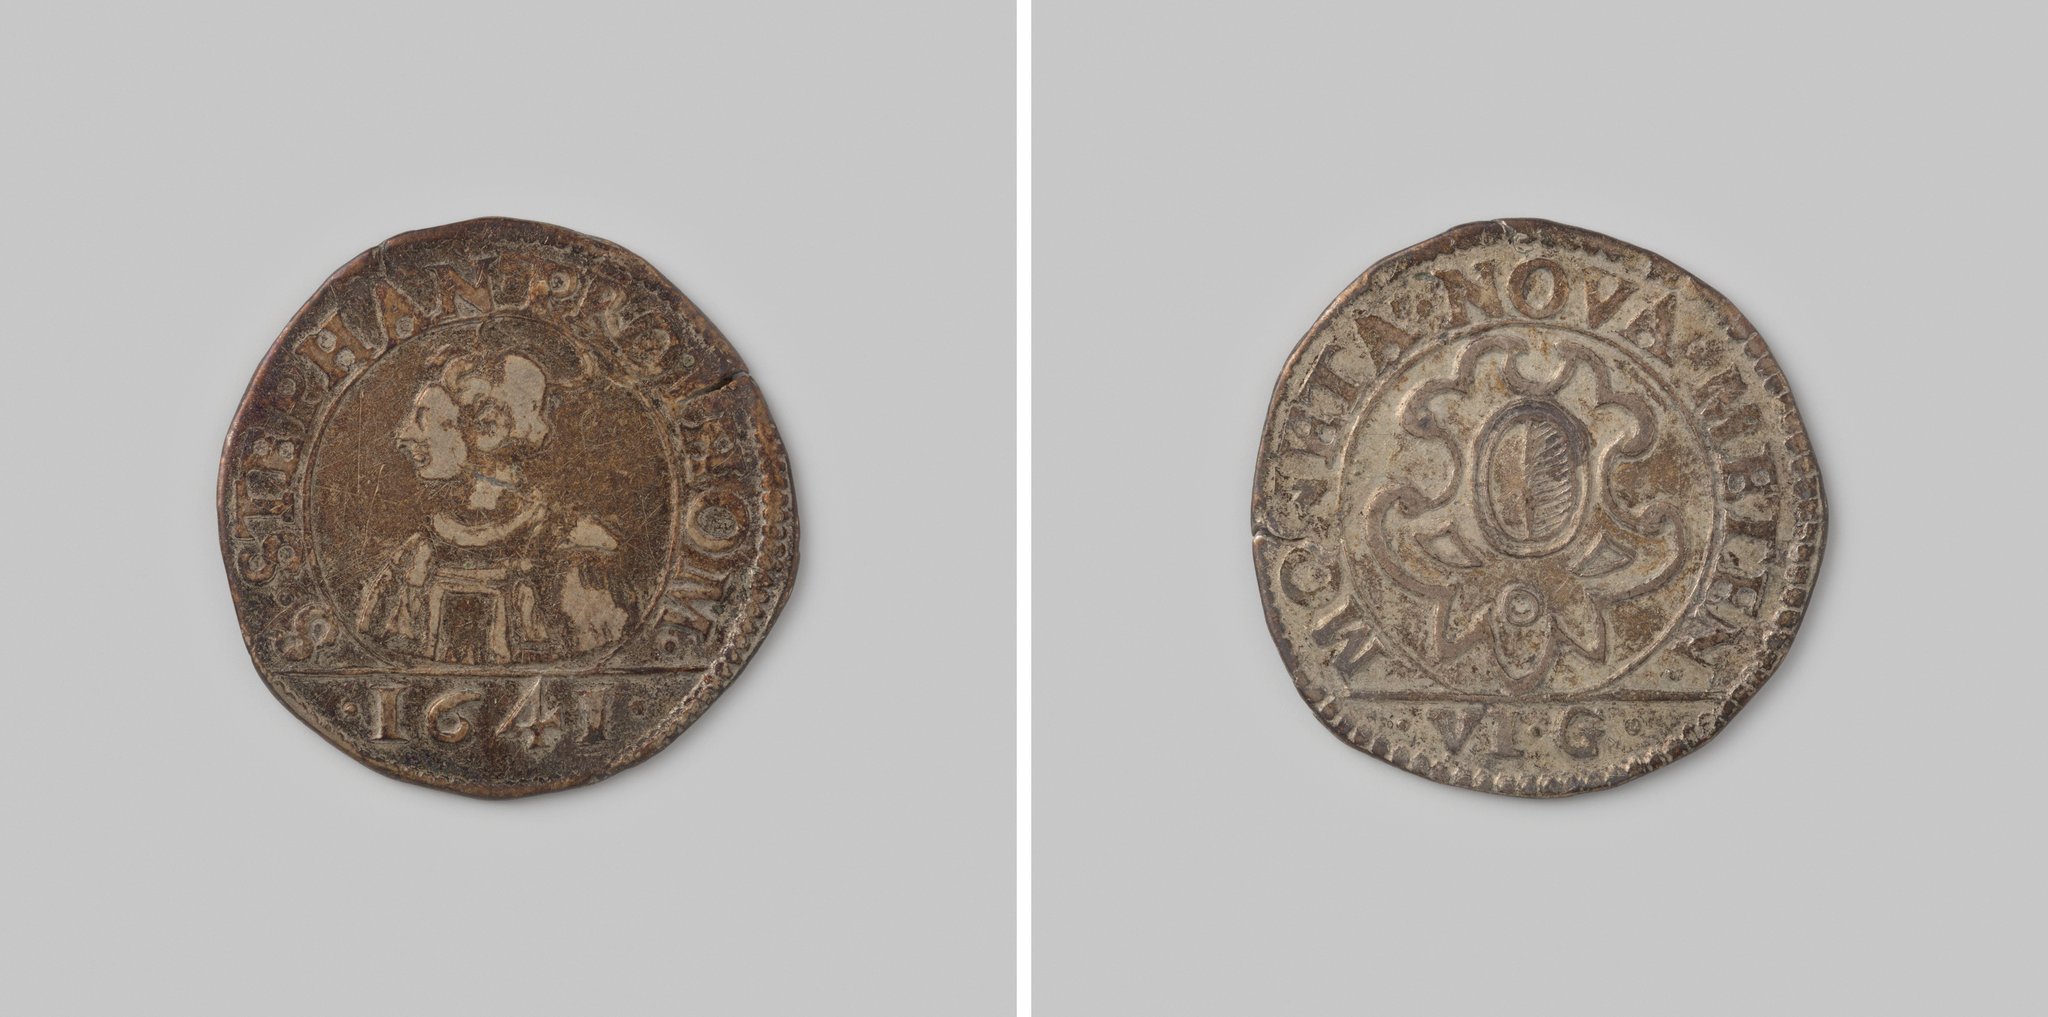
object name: coin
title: Stad Metz, 6 Groschen of ½ franc, 1641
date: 1641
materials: silver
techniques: striking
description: Zilveren munt. Voorzijde: borstbeeld van de heilige Stephanus naar links. In afsnede jaartal. Keerzijde: versierd wapenschild van de stad. In afsnede waarde-aanduiding: VI G..